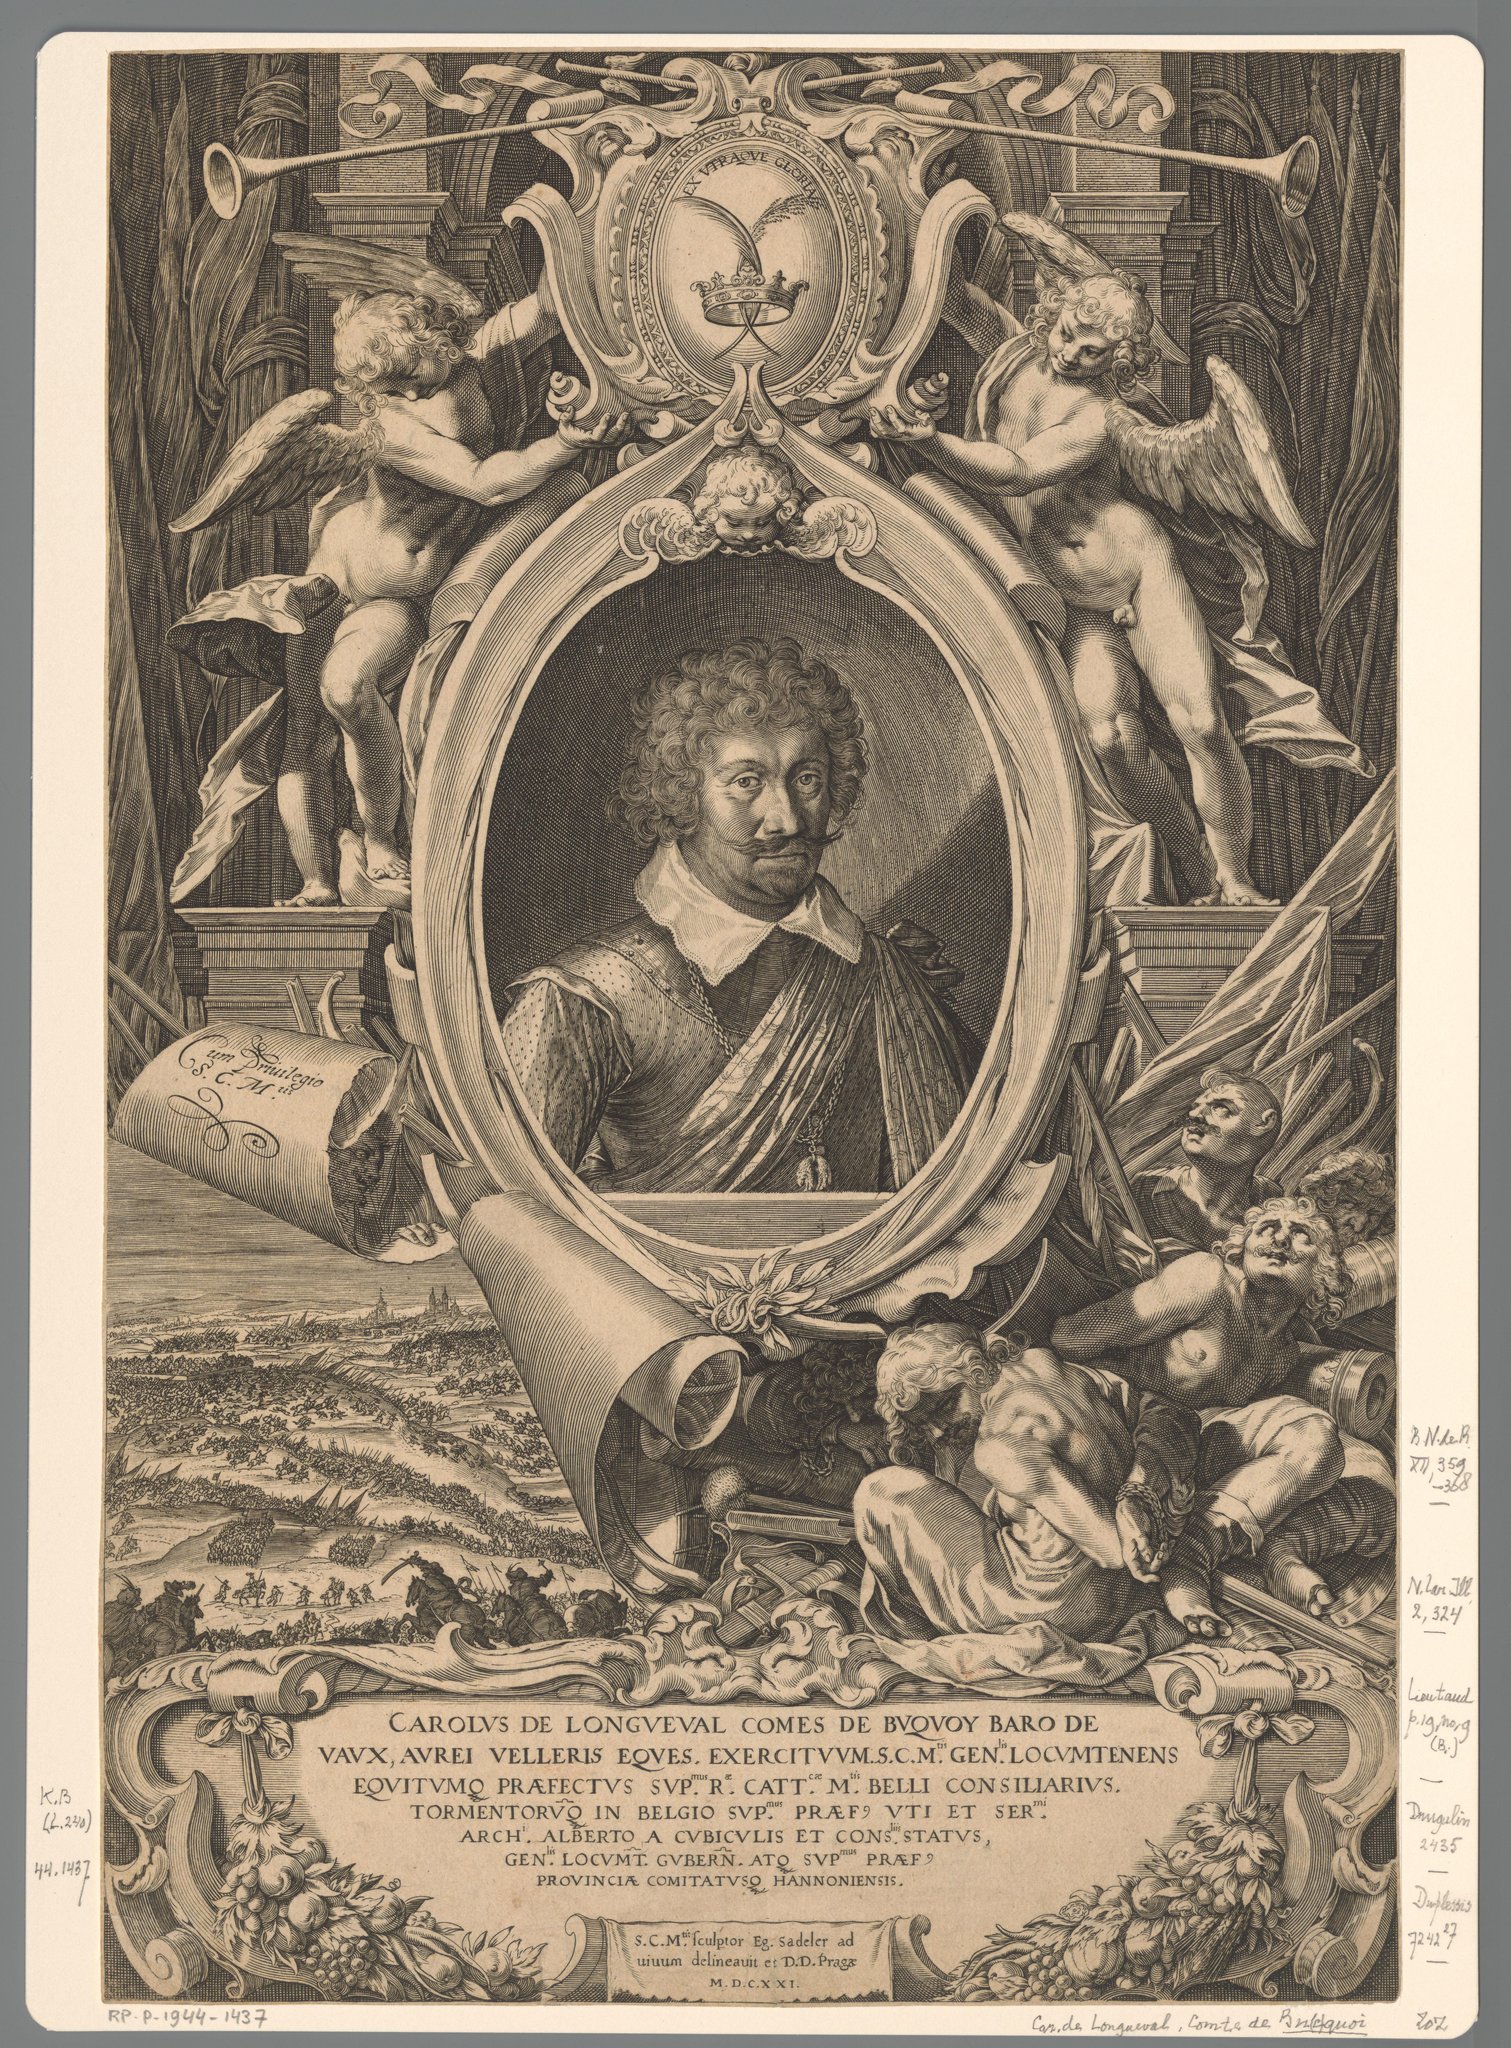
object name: print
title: Portret van Karel Bonaventura van Longueval, graaf van Bucquoy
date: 1621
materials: paper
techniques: engraving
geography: prague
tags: commander-in-chief, general, marshal, historical persons, battle, prisoner of war (after the battle), angels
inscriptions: collector's mark: Lugt 240, collector's mark: Lugt 699